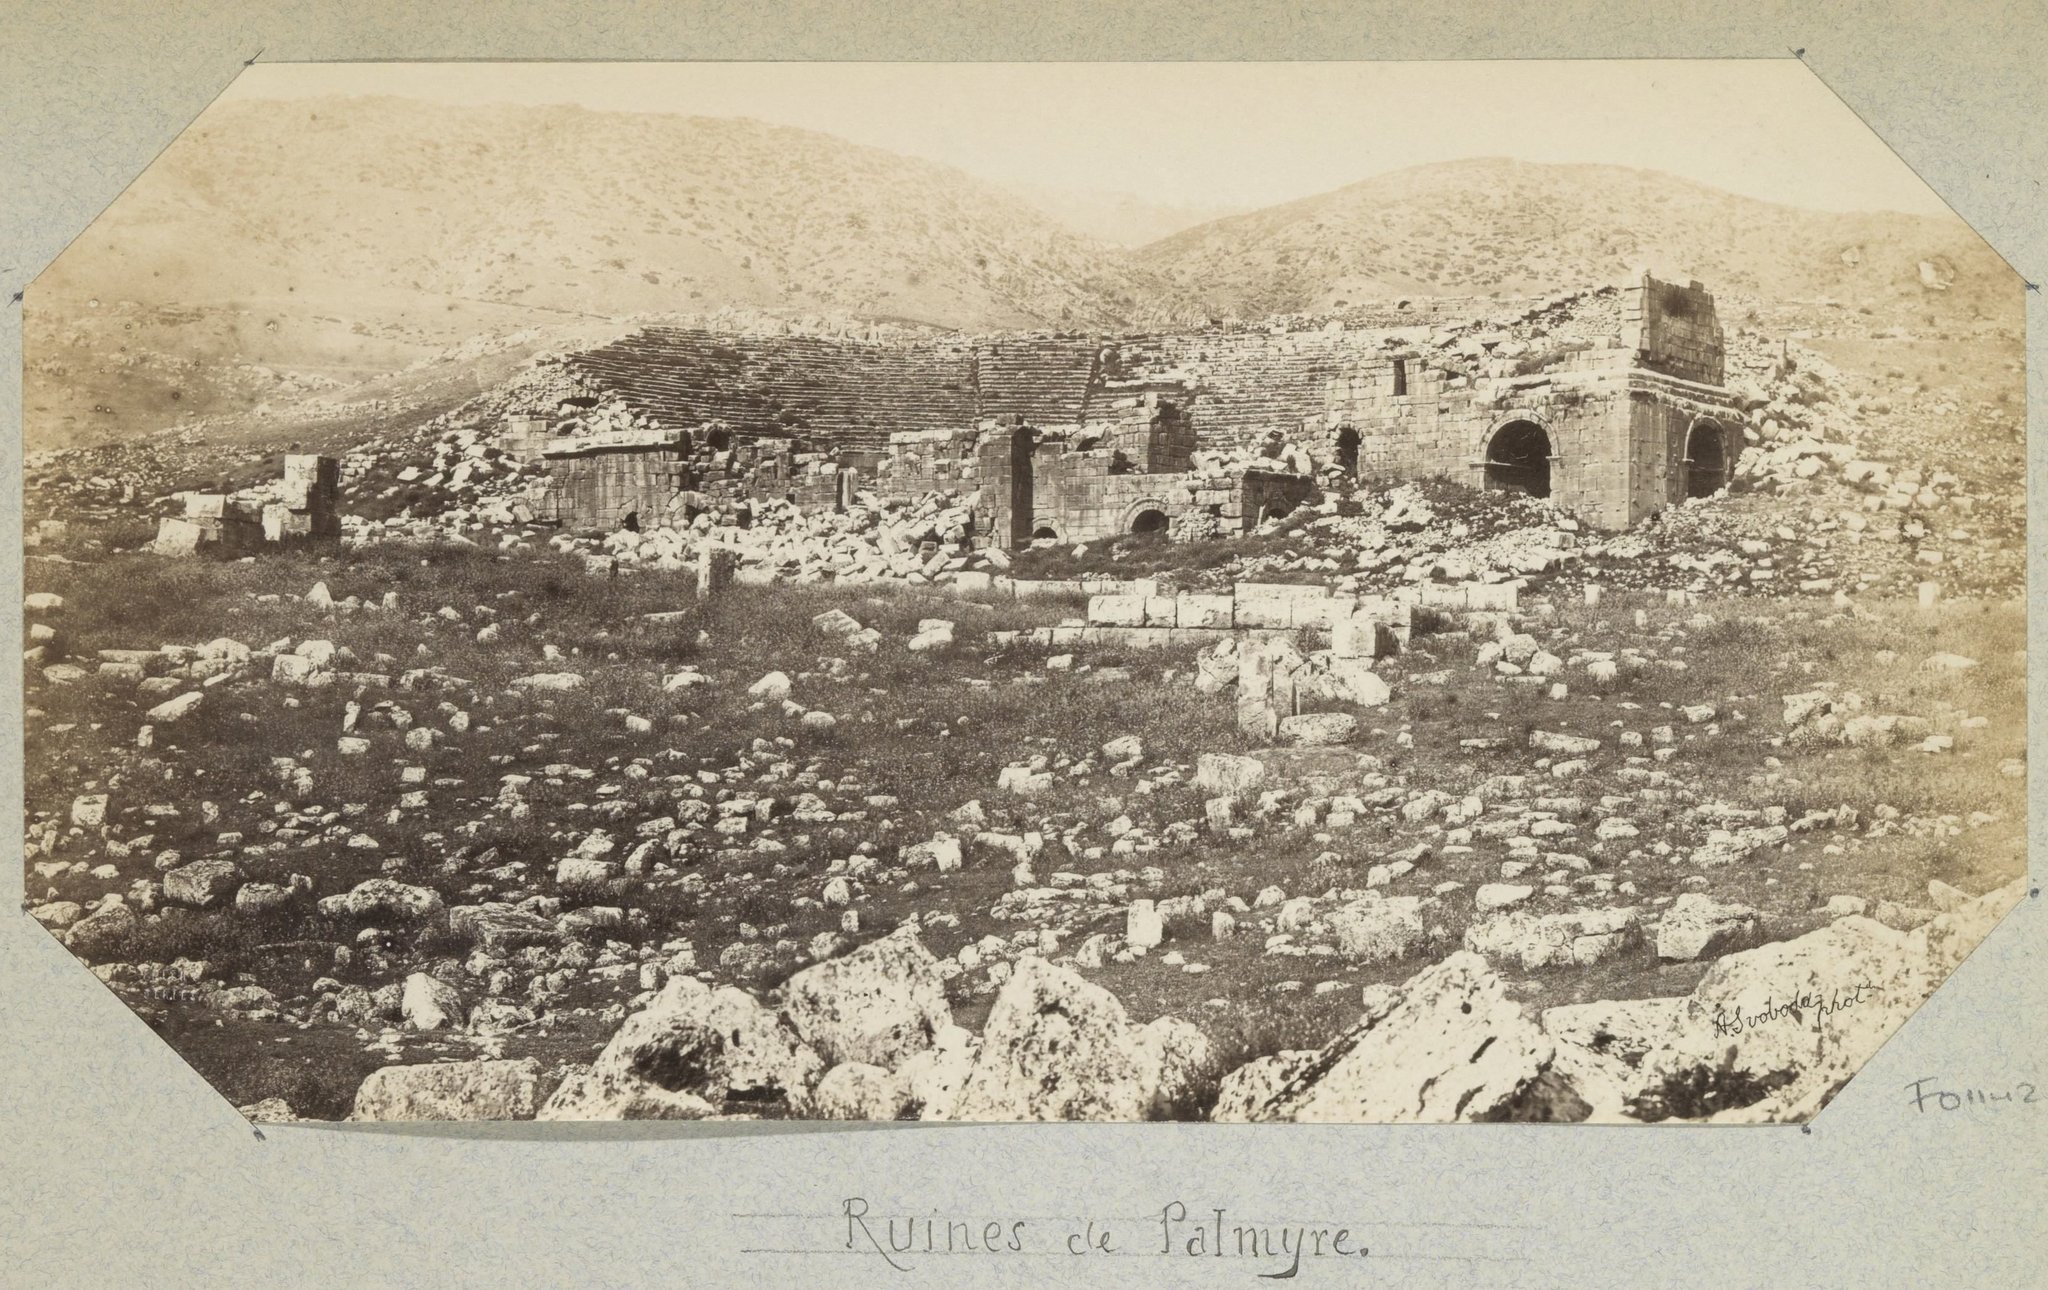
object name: album leaf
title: Restanten van gebouwen in Palmyra (Syrië)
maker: alexander svoboda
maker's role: fotograaf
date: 1880-1900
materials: paper, photographic support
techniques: albumen print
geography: palmyra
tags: ruin of a building ~ architecture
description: Onderdeel van Album van een Franse amateur met foto's van Frankrijk, Algerije, Palmyra, de Wereldtentoonstelling van 1900 en van bekende Fransen.